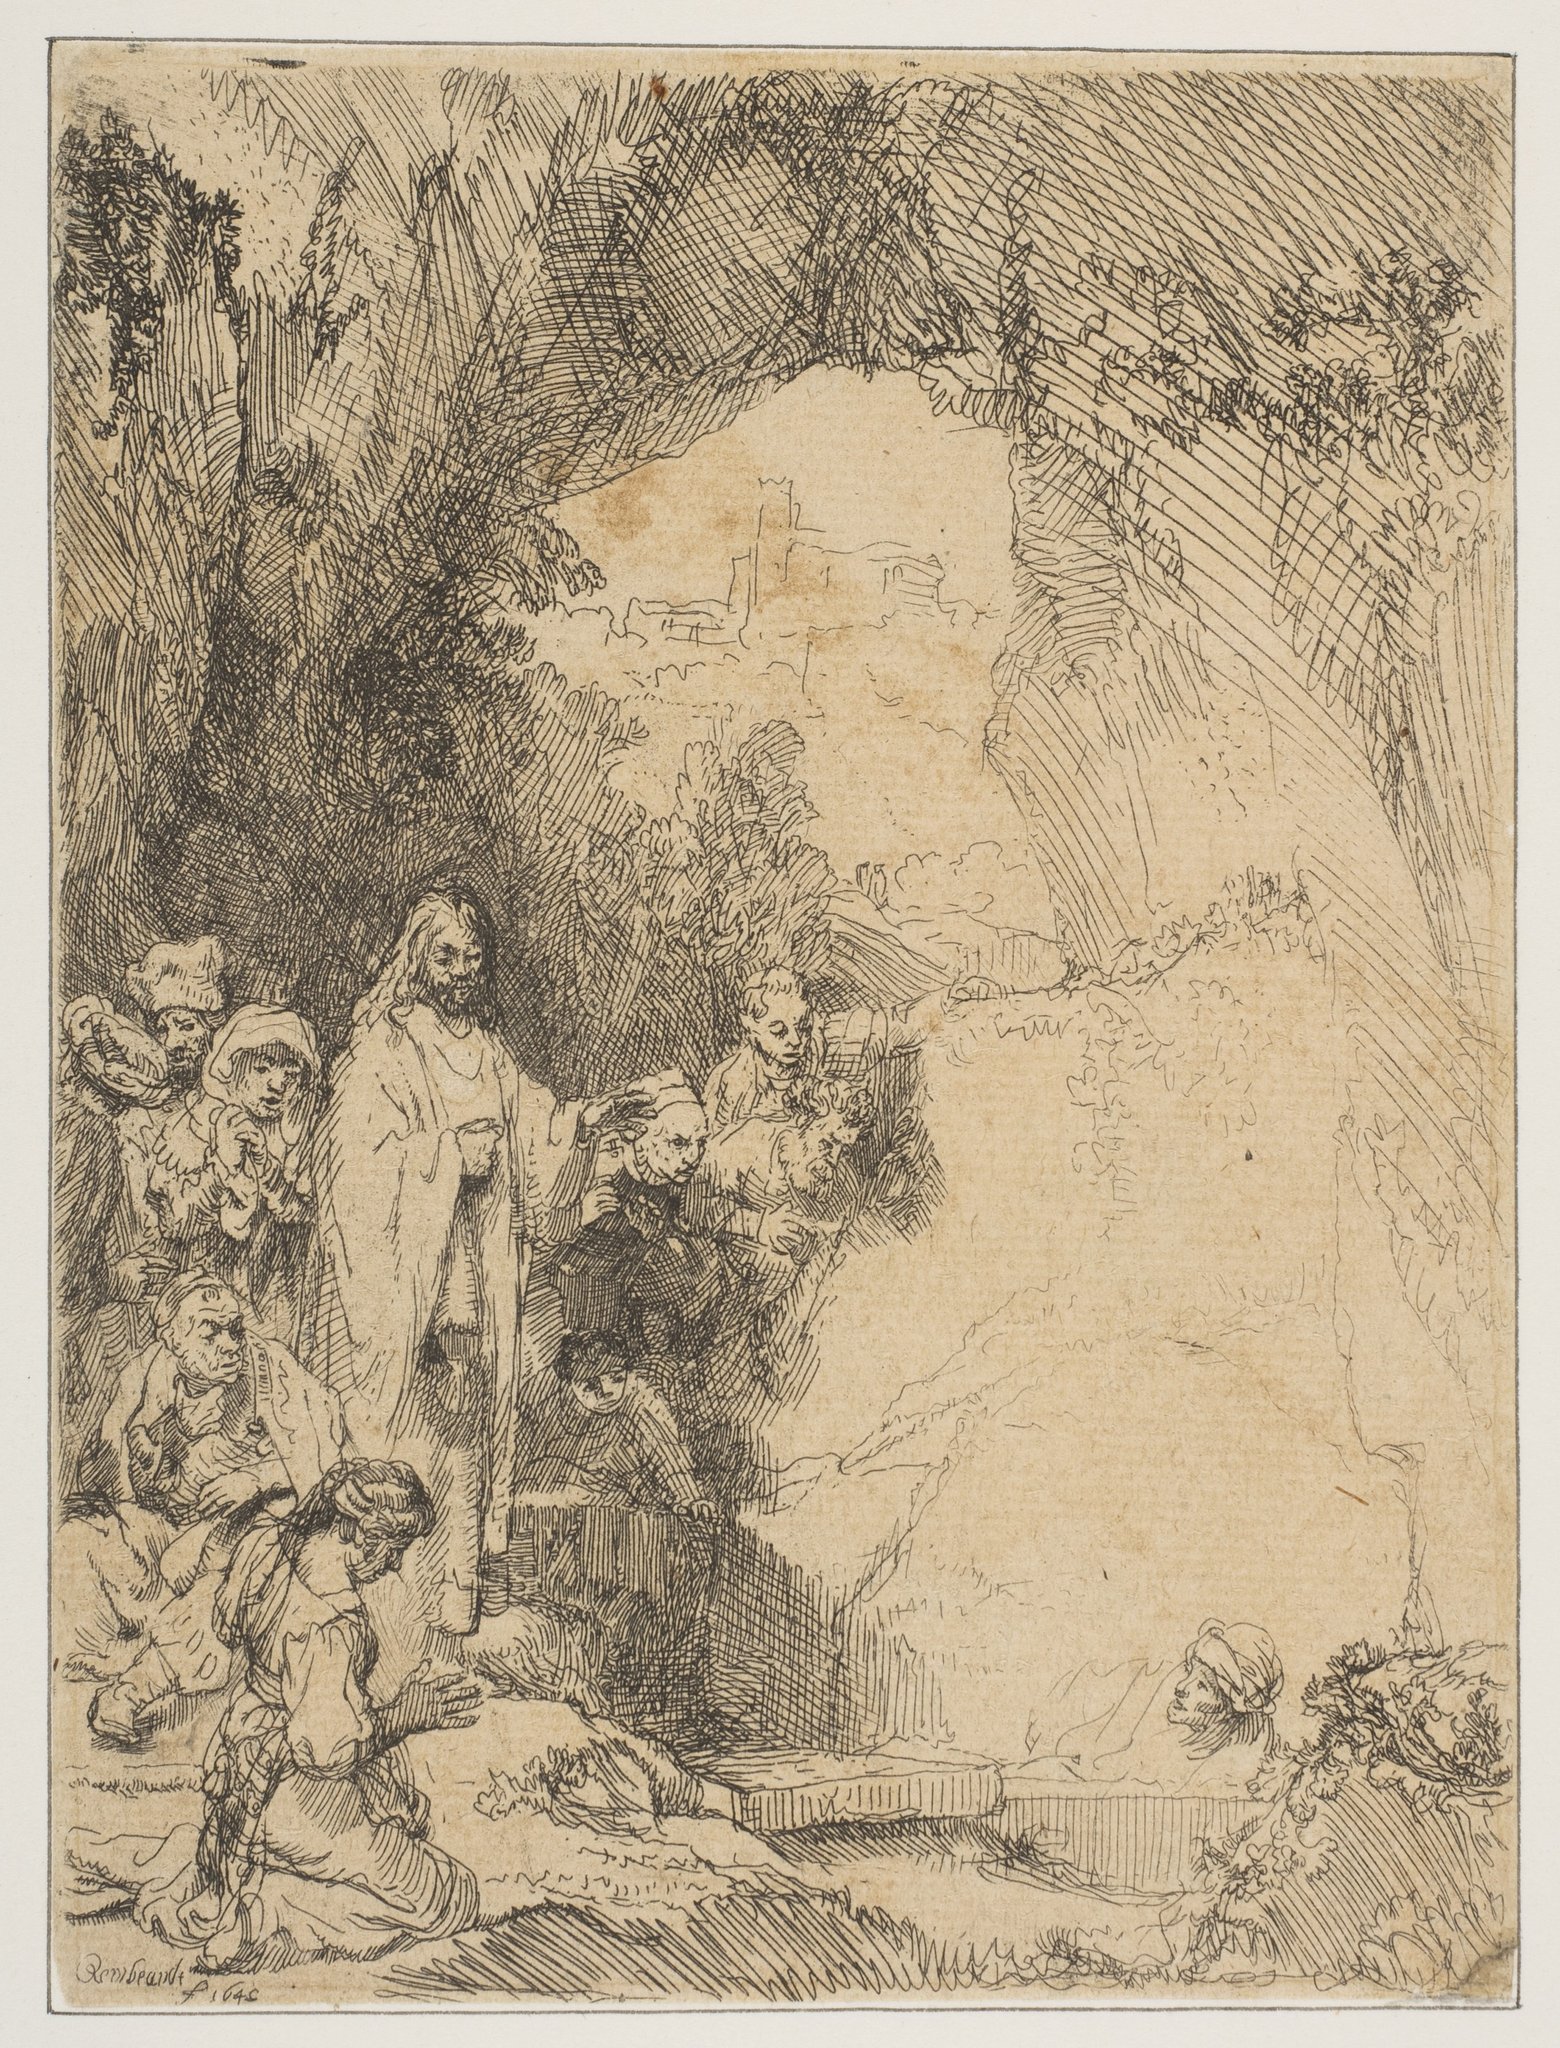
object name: print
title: The Raising of Lazarus: The Smaller Plate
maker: rembrandt van rijn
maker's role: artist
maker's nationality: dutch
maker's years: 1606-1669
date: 1642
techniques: drypoint, etching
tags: men,women,jesus